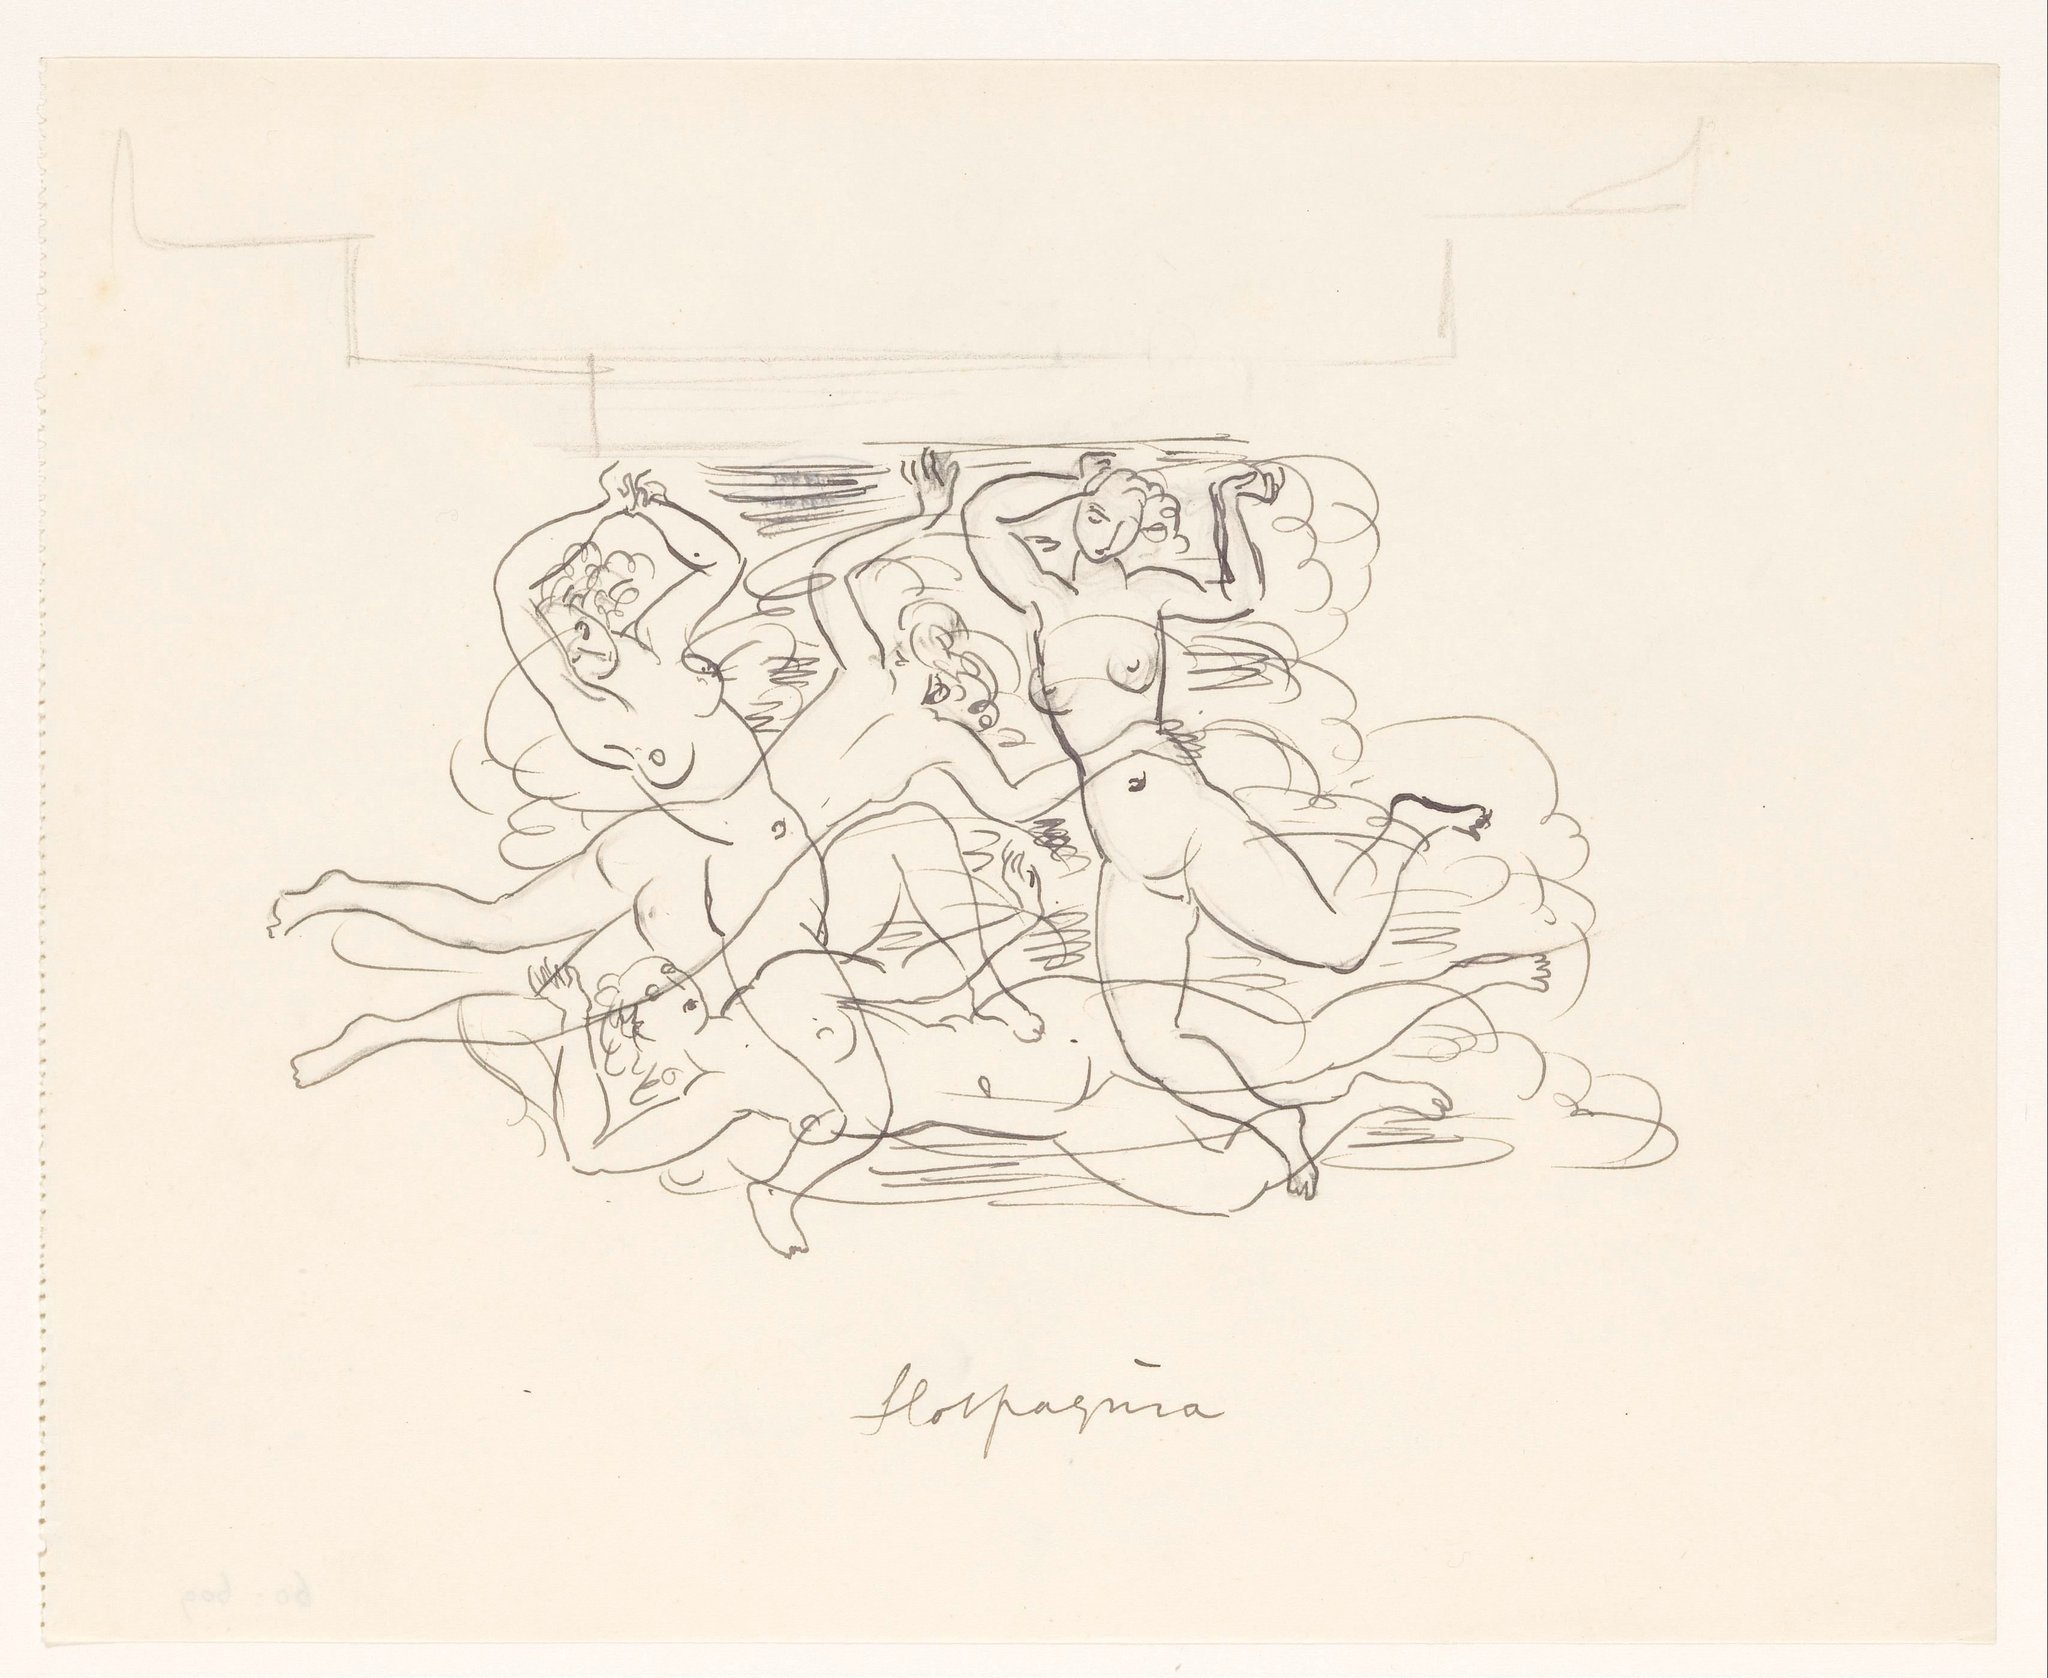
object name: drawing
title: Naakte vrouwen, zwemmend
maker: leo gestel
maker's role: draughtsman, print maker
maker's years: 1881-1941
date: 1891-1941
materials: ink, paper, pencil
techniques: pen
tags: swimming (movement in water) - aa - female human figure (+ nude human being)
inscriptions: collector's mark: Lugt 2228, watermark: ‘GW/ papier/ 1671’, :